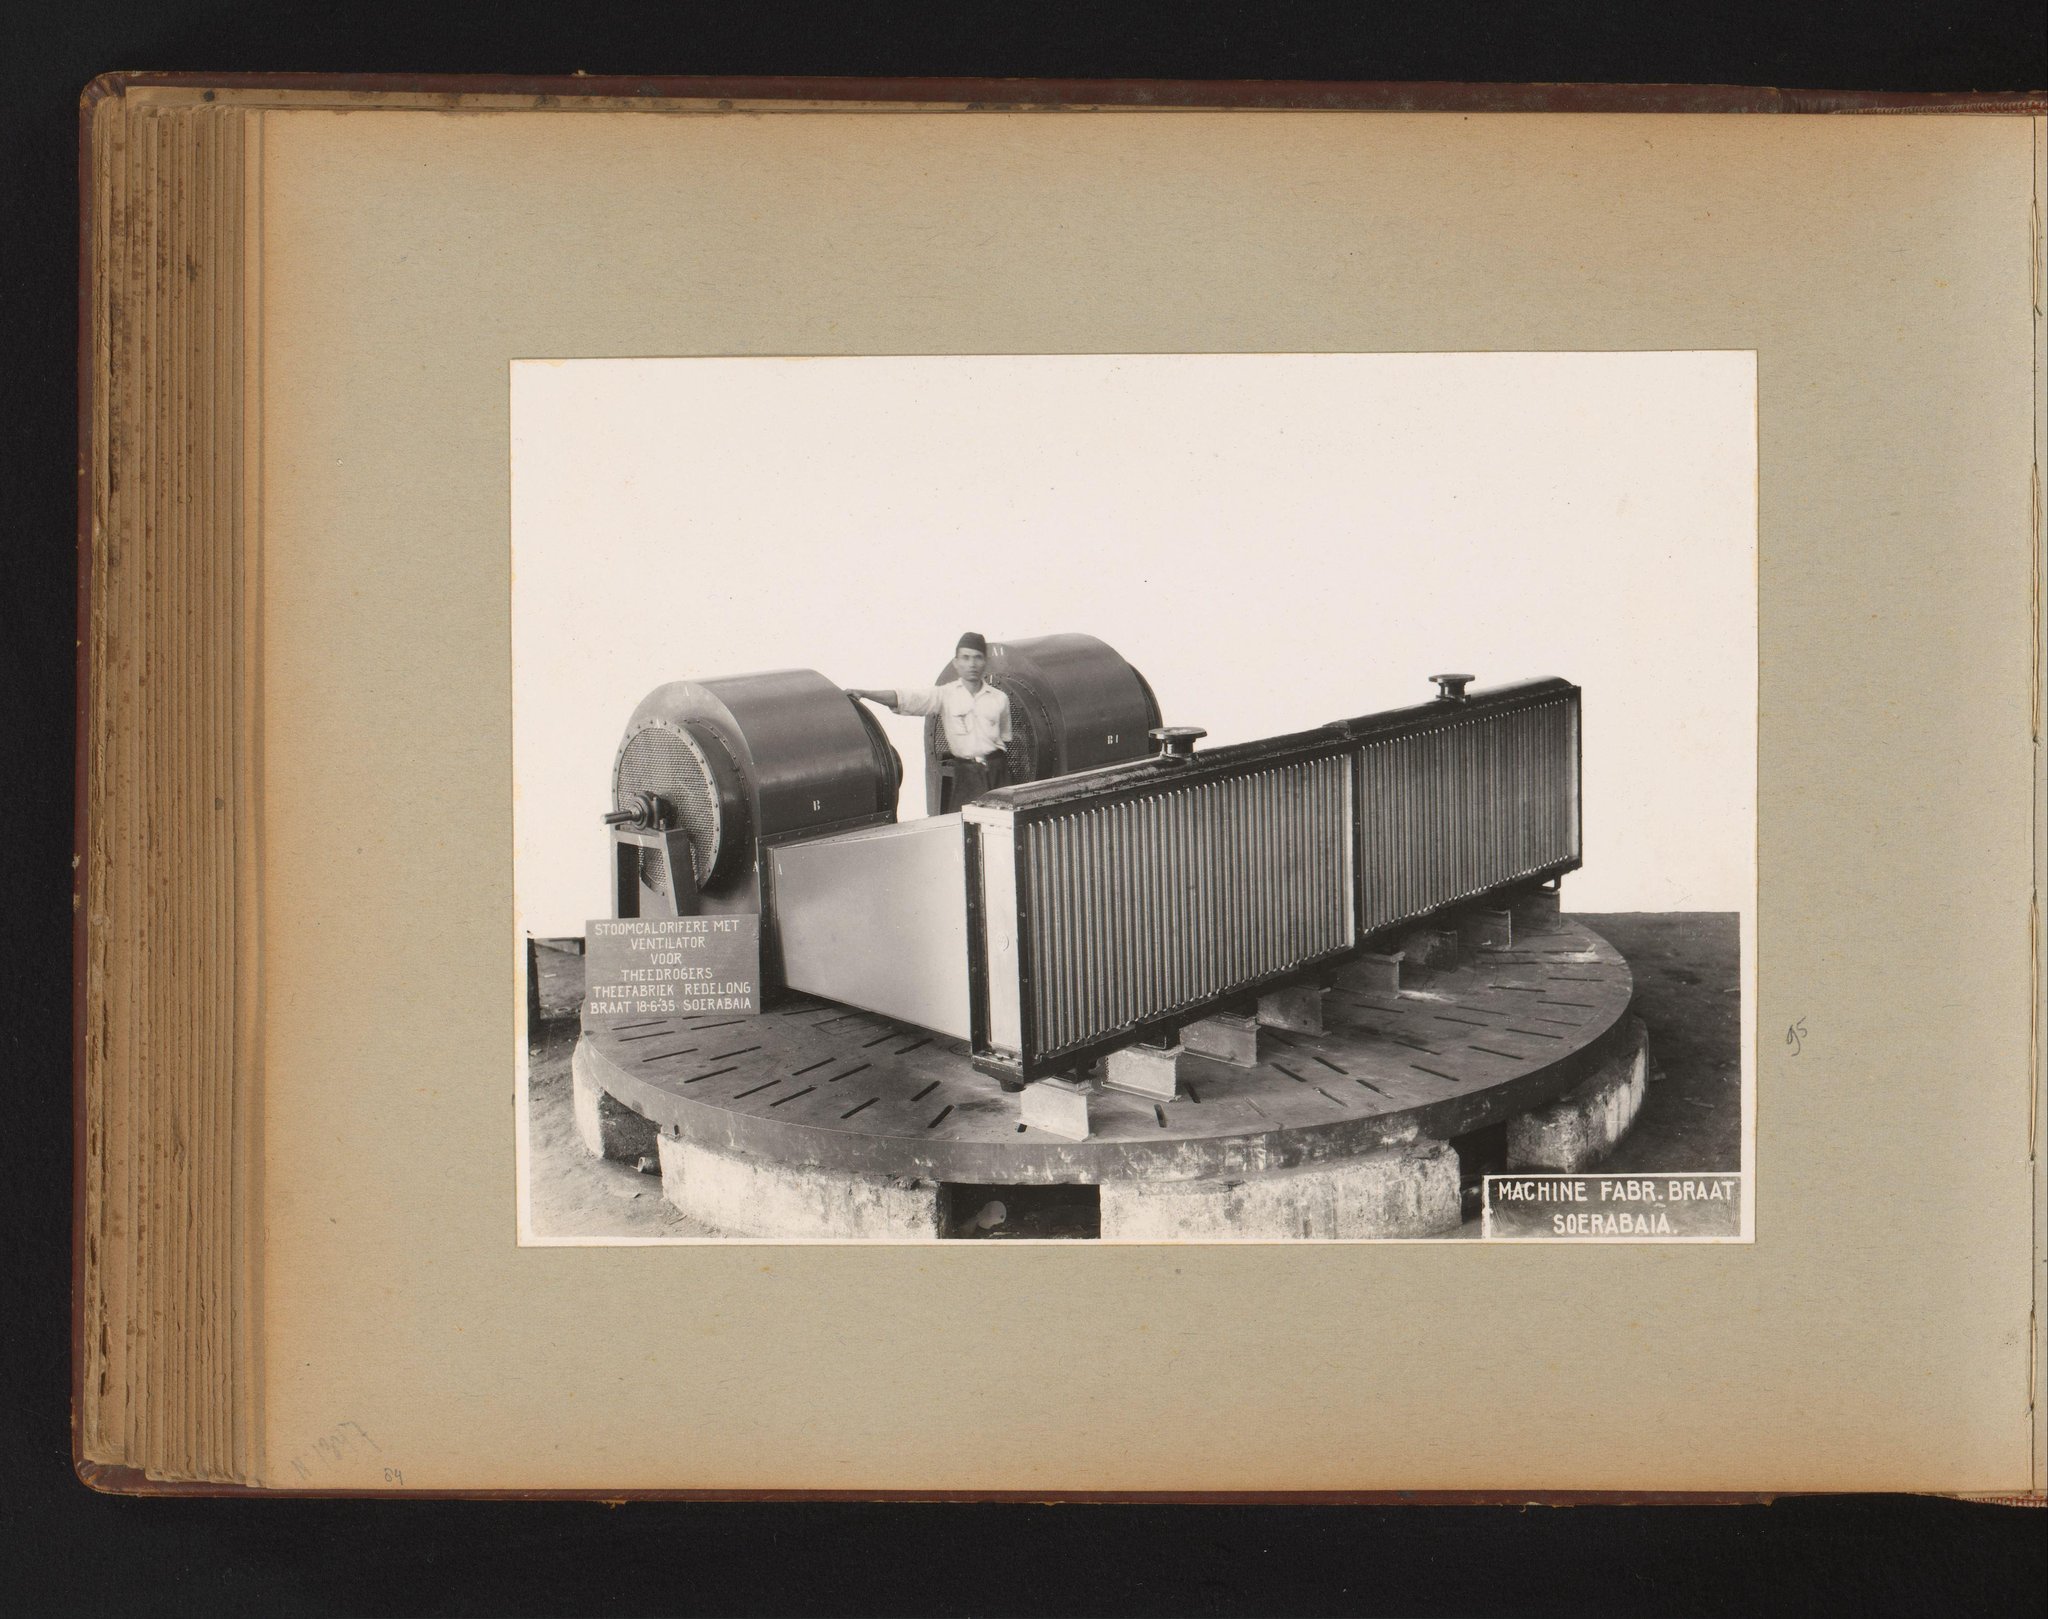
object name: album leaf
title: Stoommachine met ventilator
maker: Anonymous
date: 1935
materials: cardboard, photographic support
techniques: gelatin silver print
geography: surabaya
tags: machines; parts of machines; tools and appliances, ventilation systems, surabaya, java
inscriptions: date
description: Albumblad met een foto van een stoommachine met ventilator, bestemd voor de theefabriek Reelong, 18 juni 1935. Onderdeel van een fotoalbum met foto's van machines en constructies van de N.V. Machinefabriek Braat te Soerabaja, Soekaboemi en Tegal uit de periode 1931-1937.